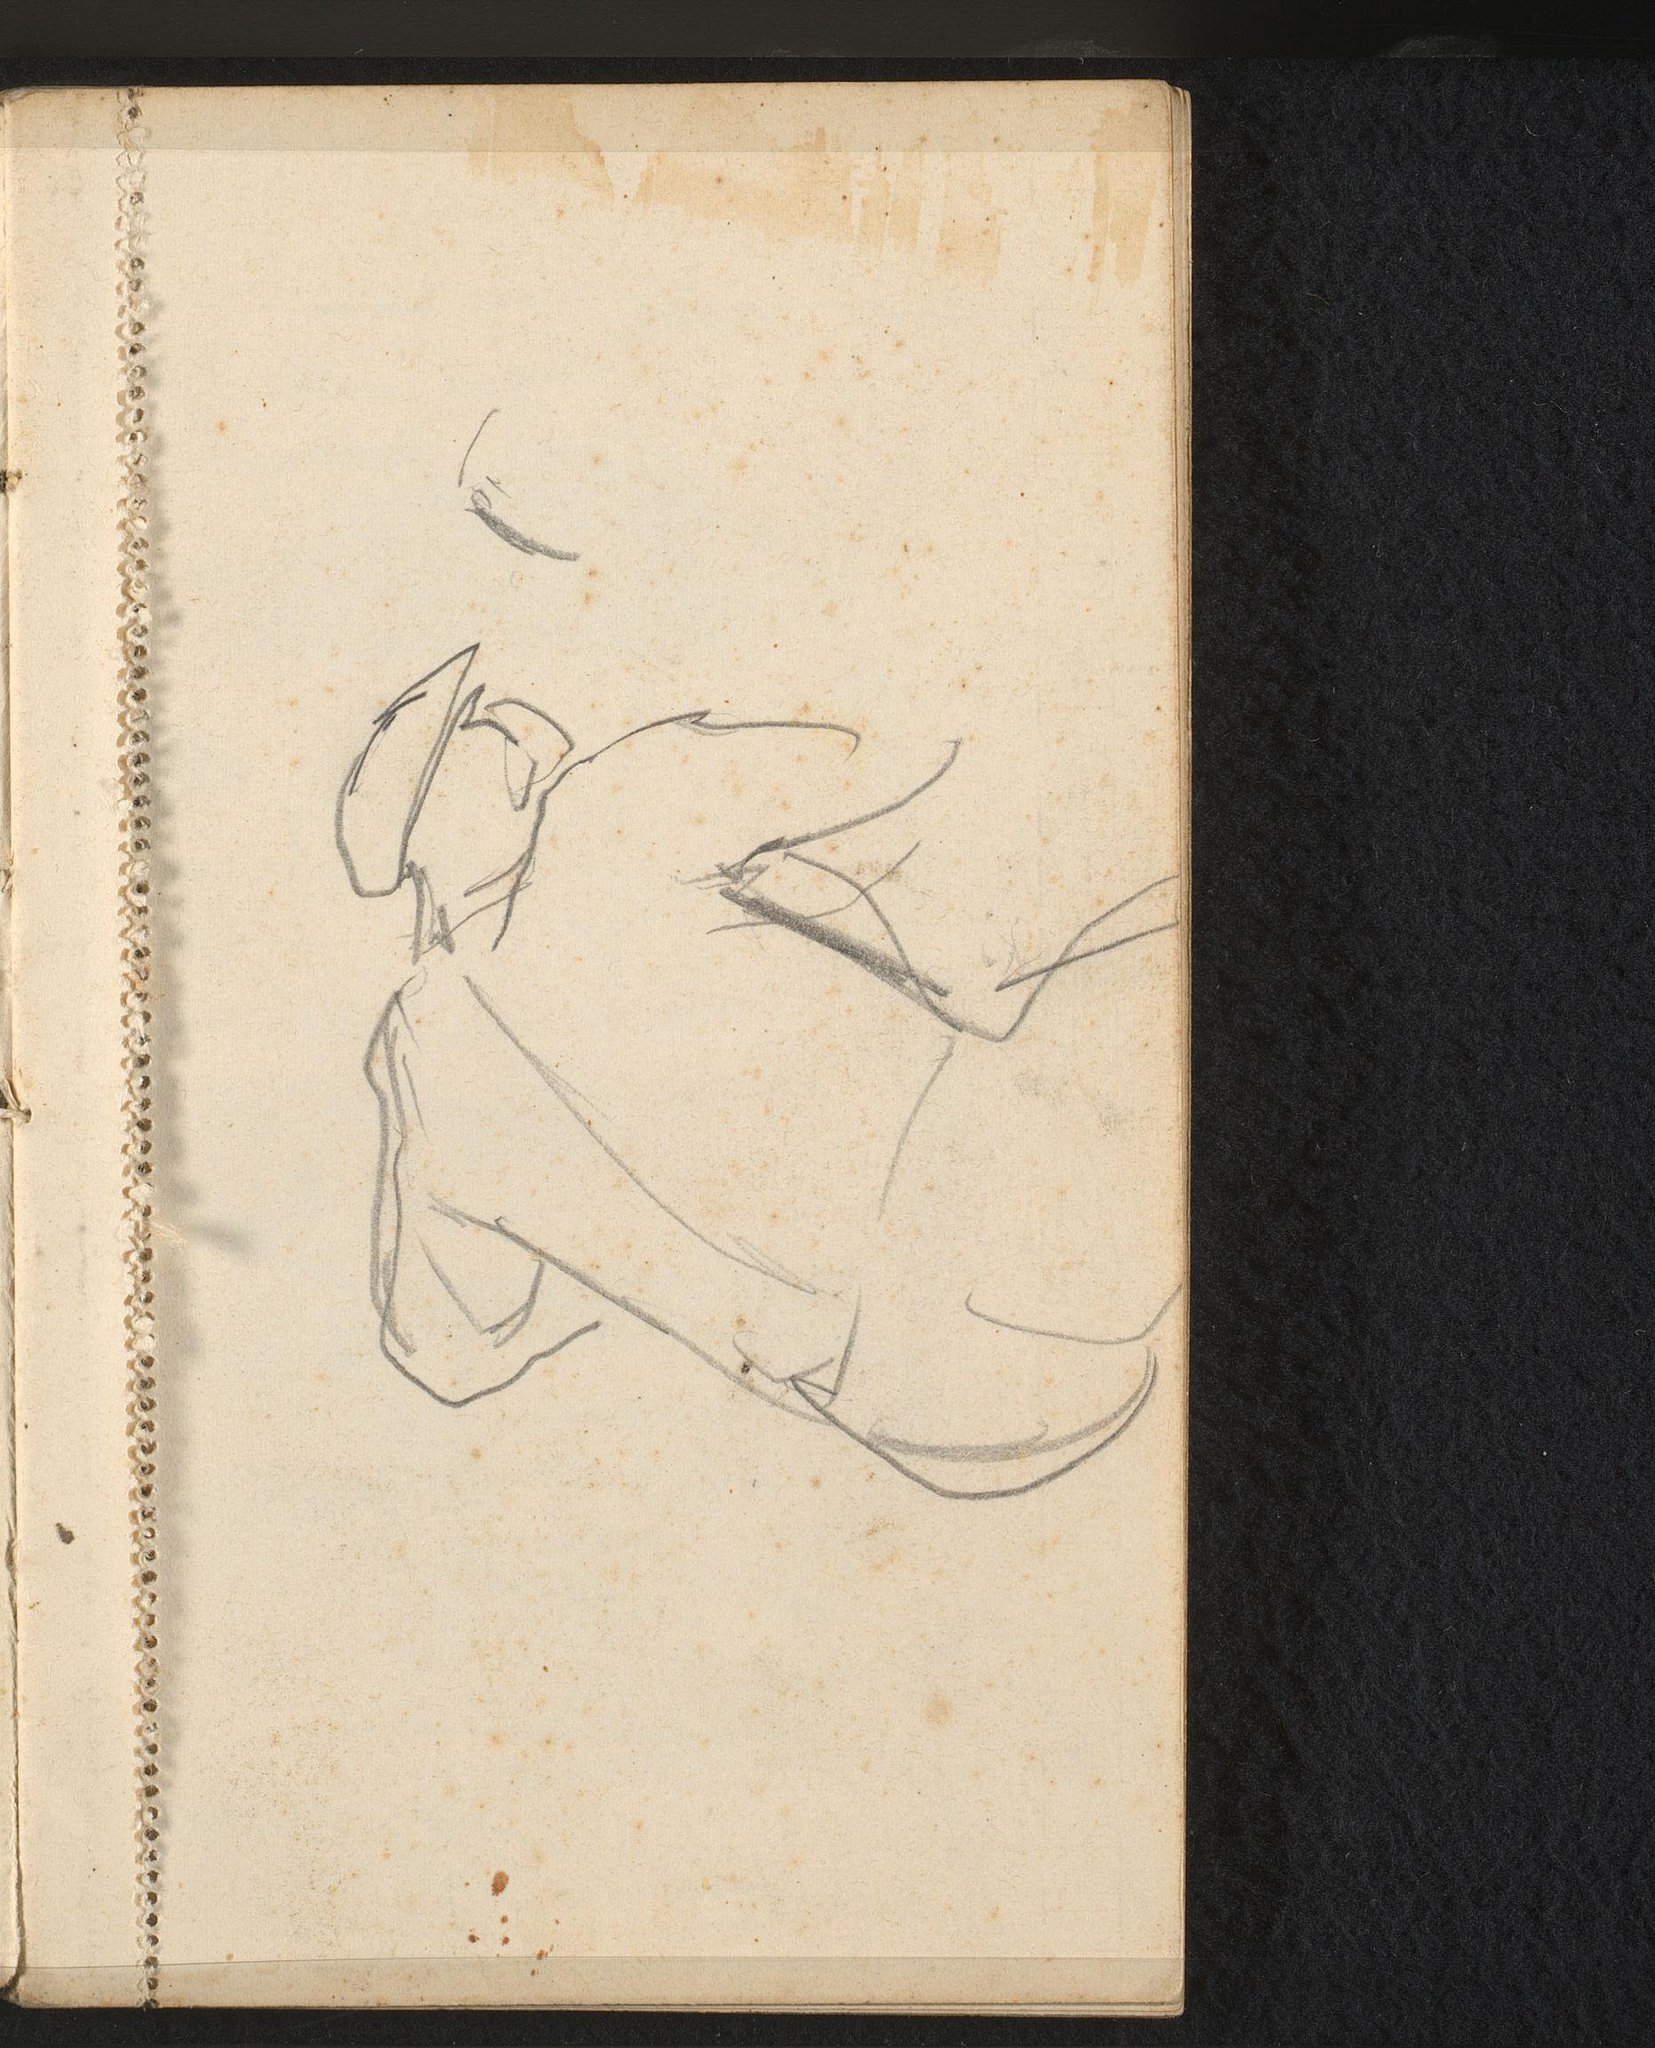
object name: sketchbook leaf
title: Man met pet op de rug gezien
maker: gerrit van blaaderen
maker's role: draughtsman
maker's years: 1873-1935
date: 1908-1927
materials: paper, pencil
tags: adult man (+ back view), head-gear: cap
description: Blad 1 recto uit een schetsboek met 33 bladen.